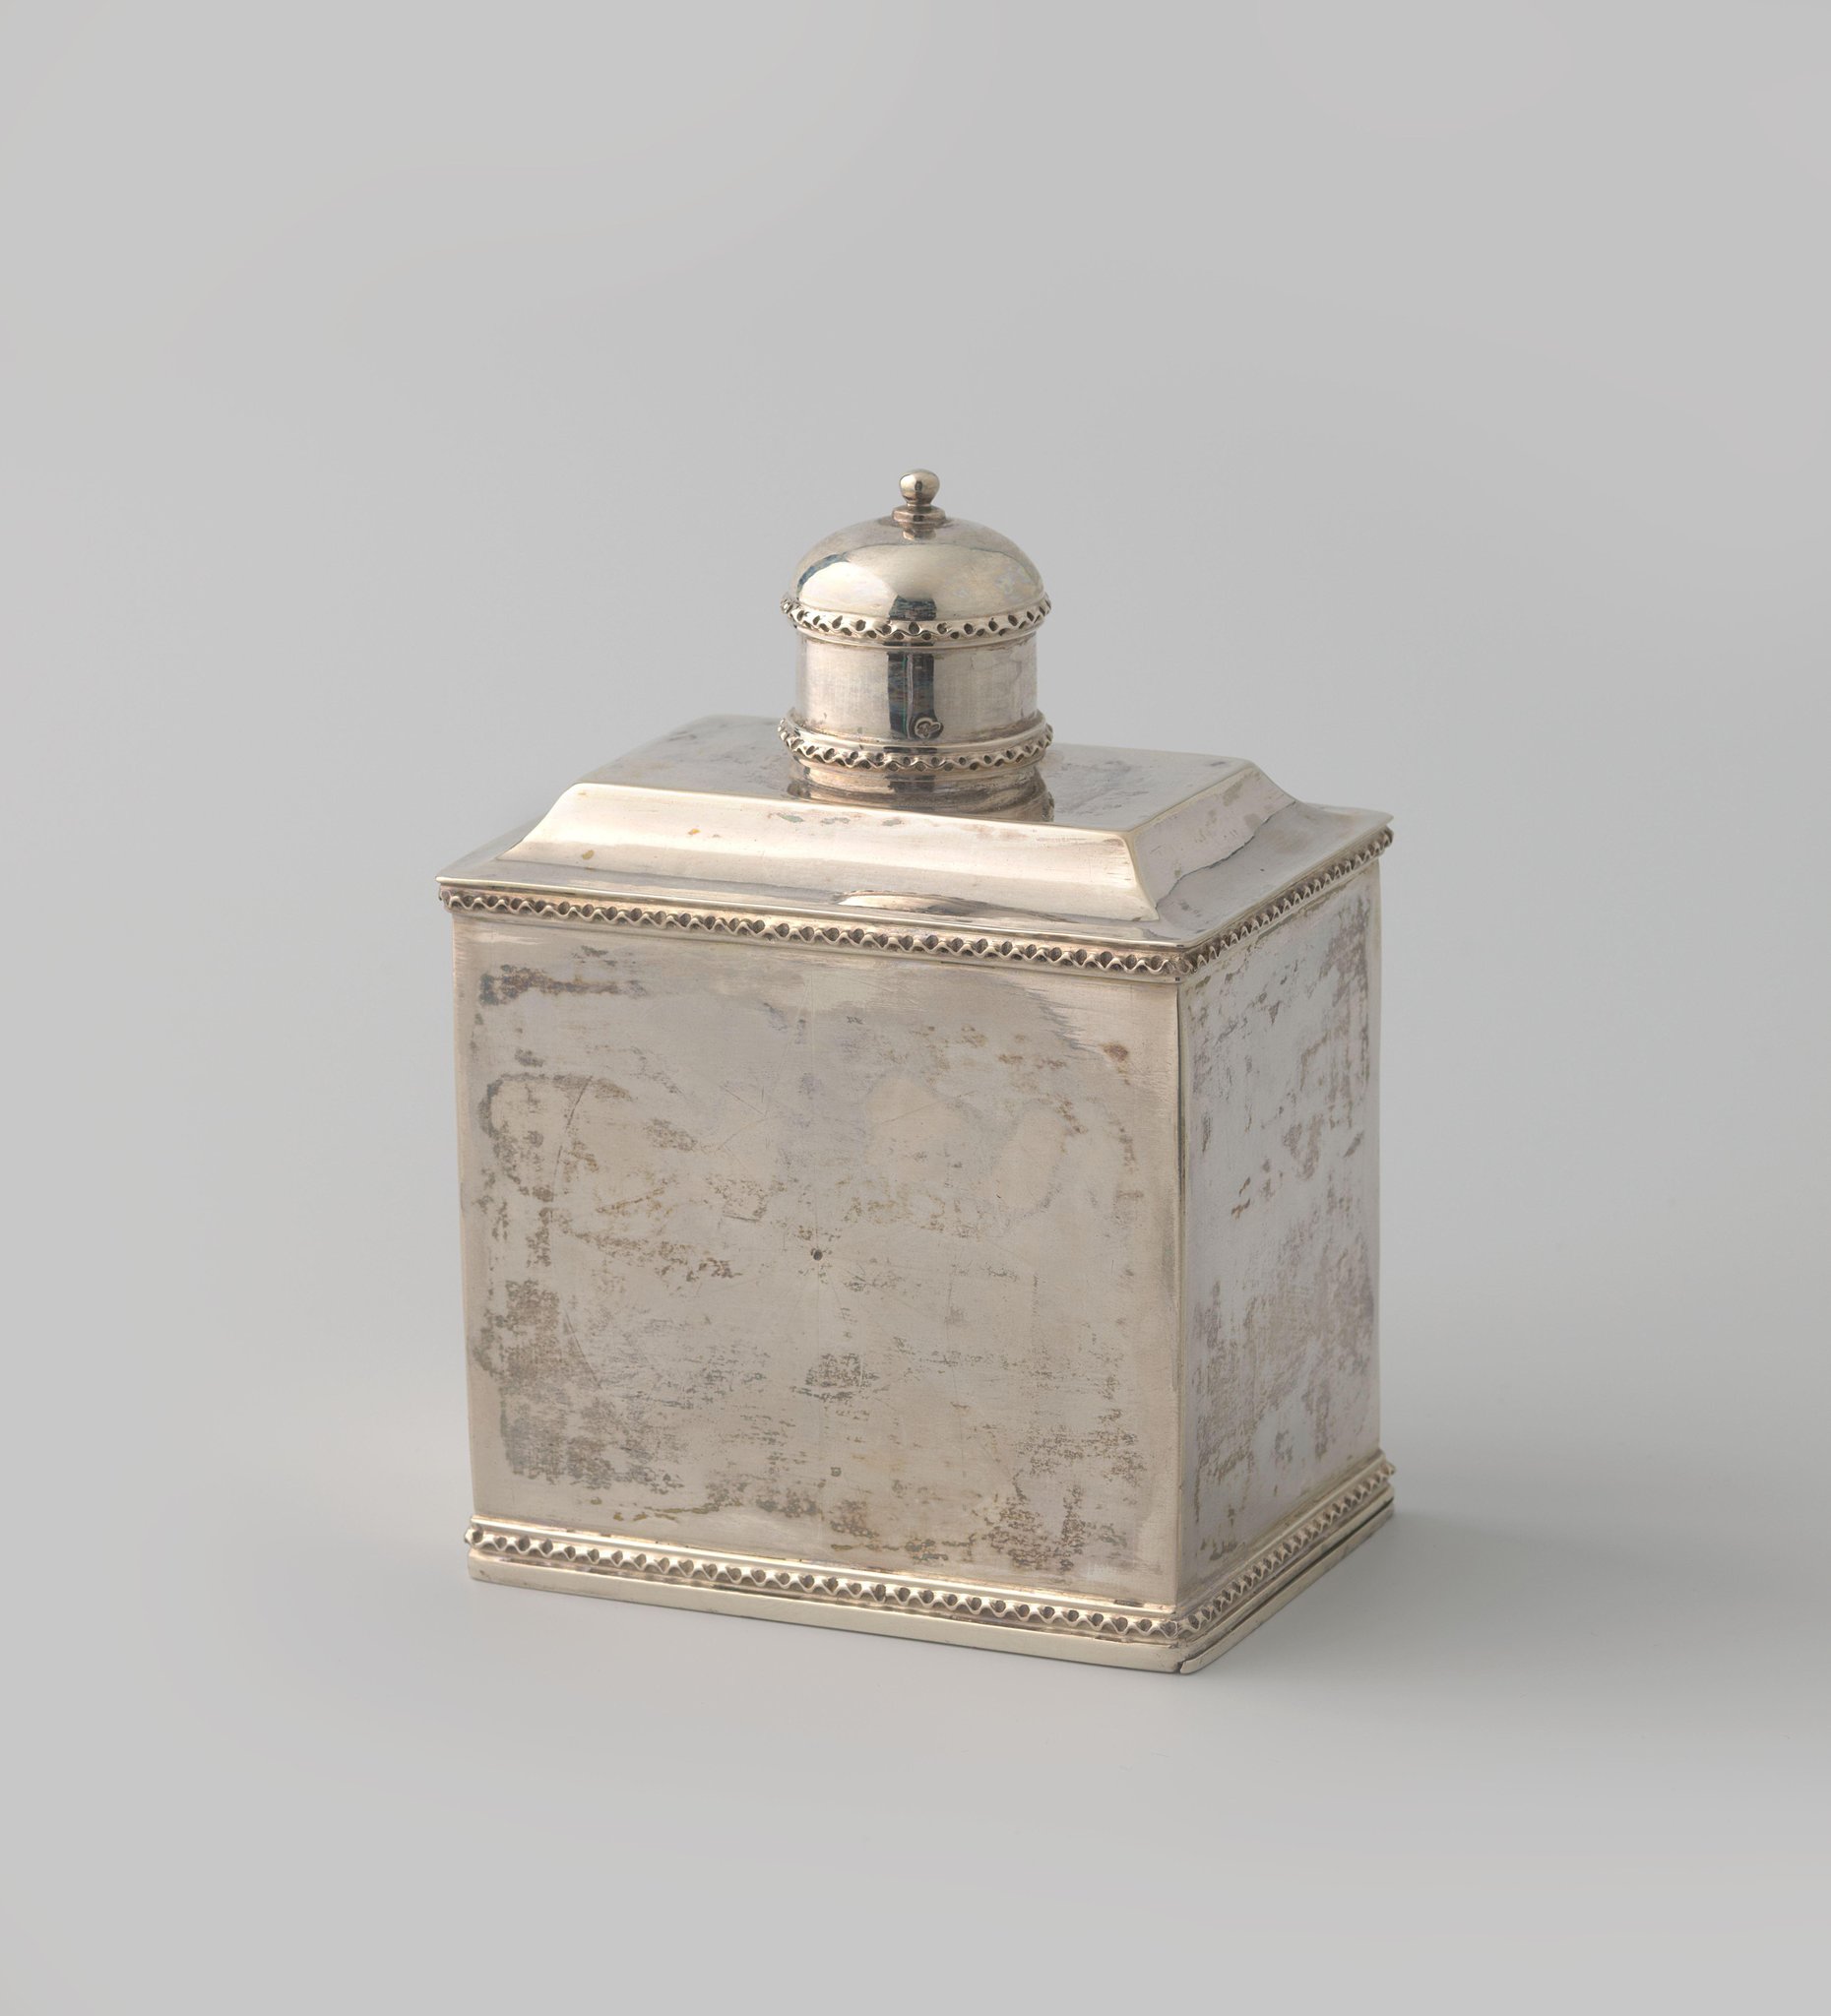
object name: tea caddy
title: Theebus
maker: dionysius van hensboom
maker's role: silversmith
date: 1732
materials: silver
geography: zwolle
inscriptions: mark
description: Tea caddy. Silver. Zwolle, 1732, by Dionysius van Hensboom.